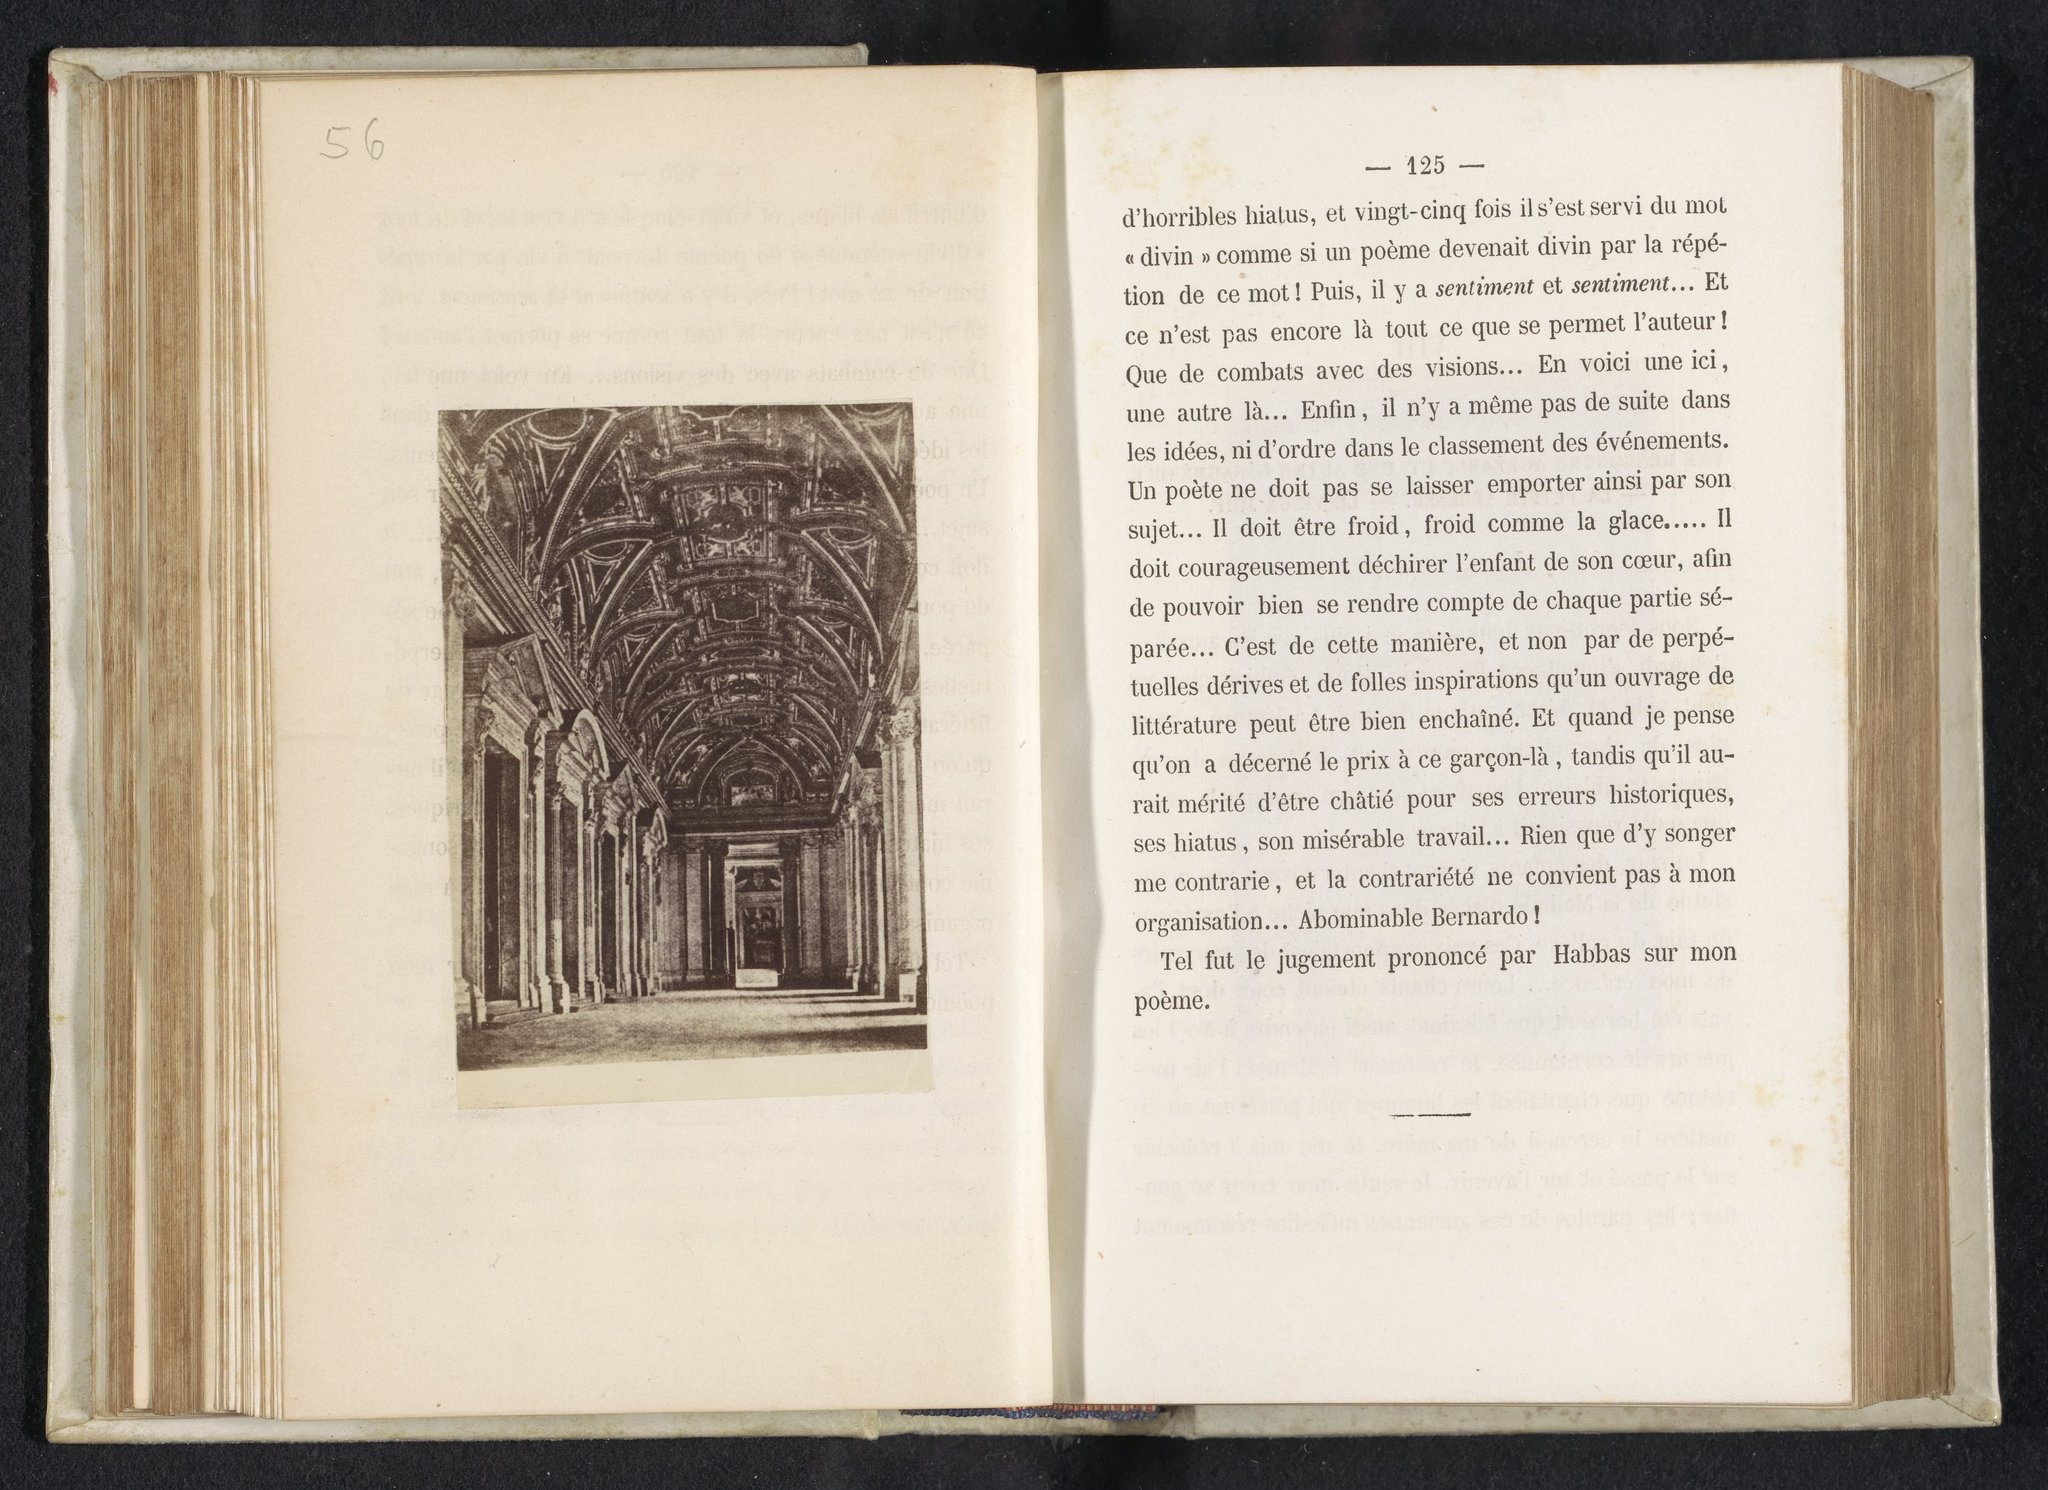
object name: page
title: Interieur van een vestibule (vermoedelijk) te Rome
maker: Anonymous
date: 1850-1860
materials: photographic support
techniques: albumen print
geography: rome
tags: vestibule, hall, interior ~ representation of a building